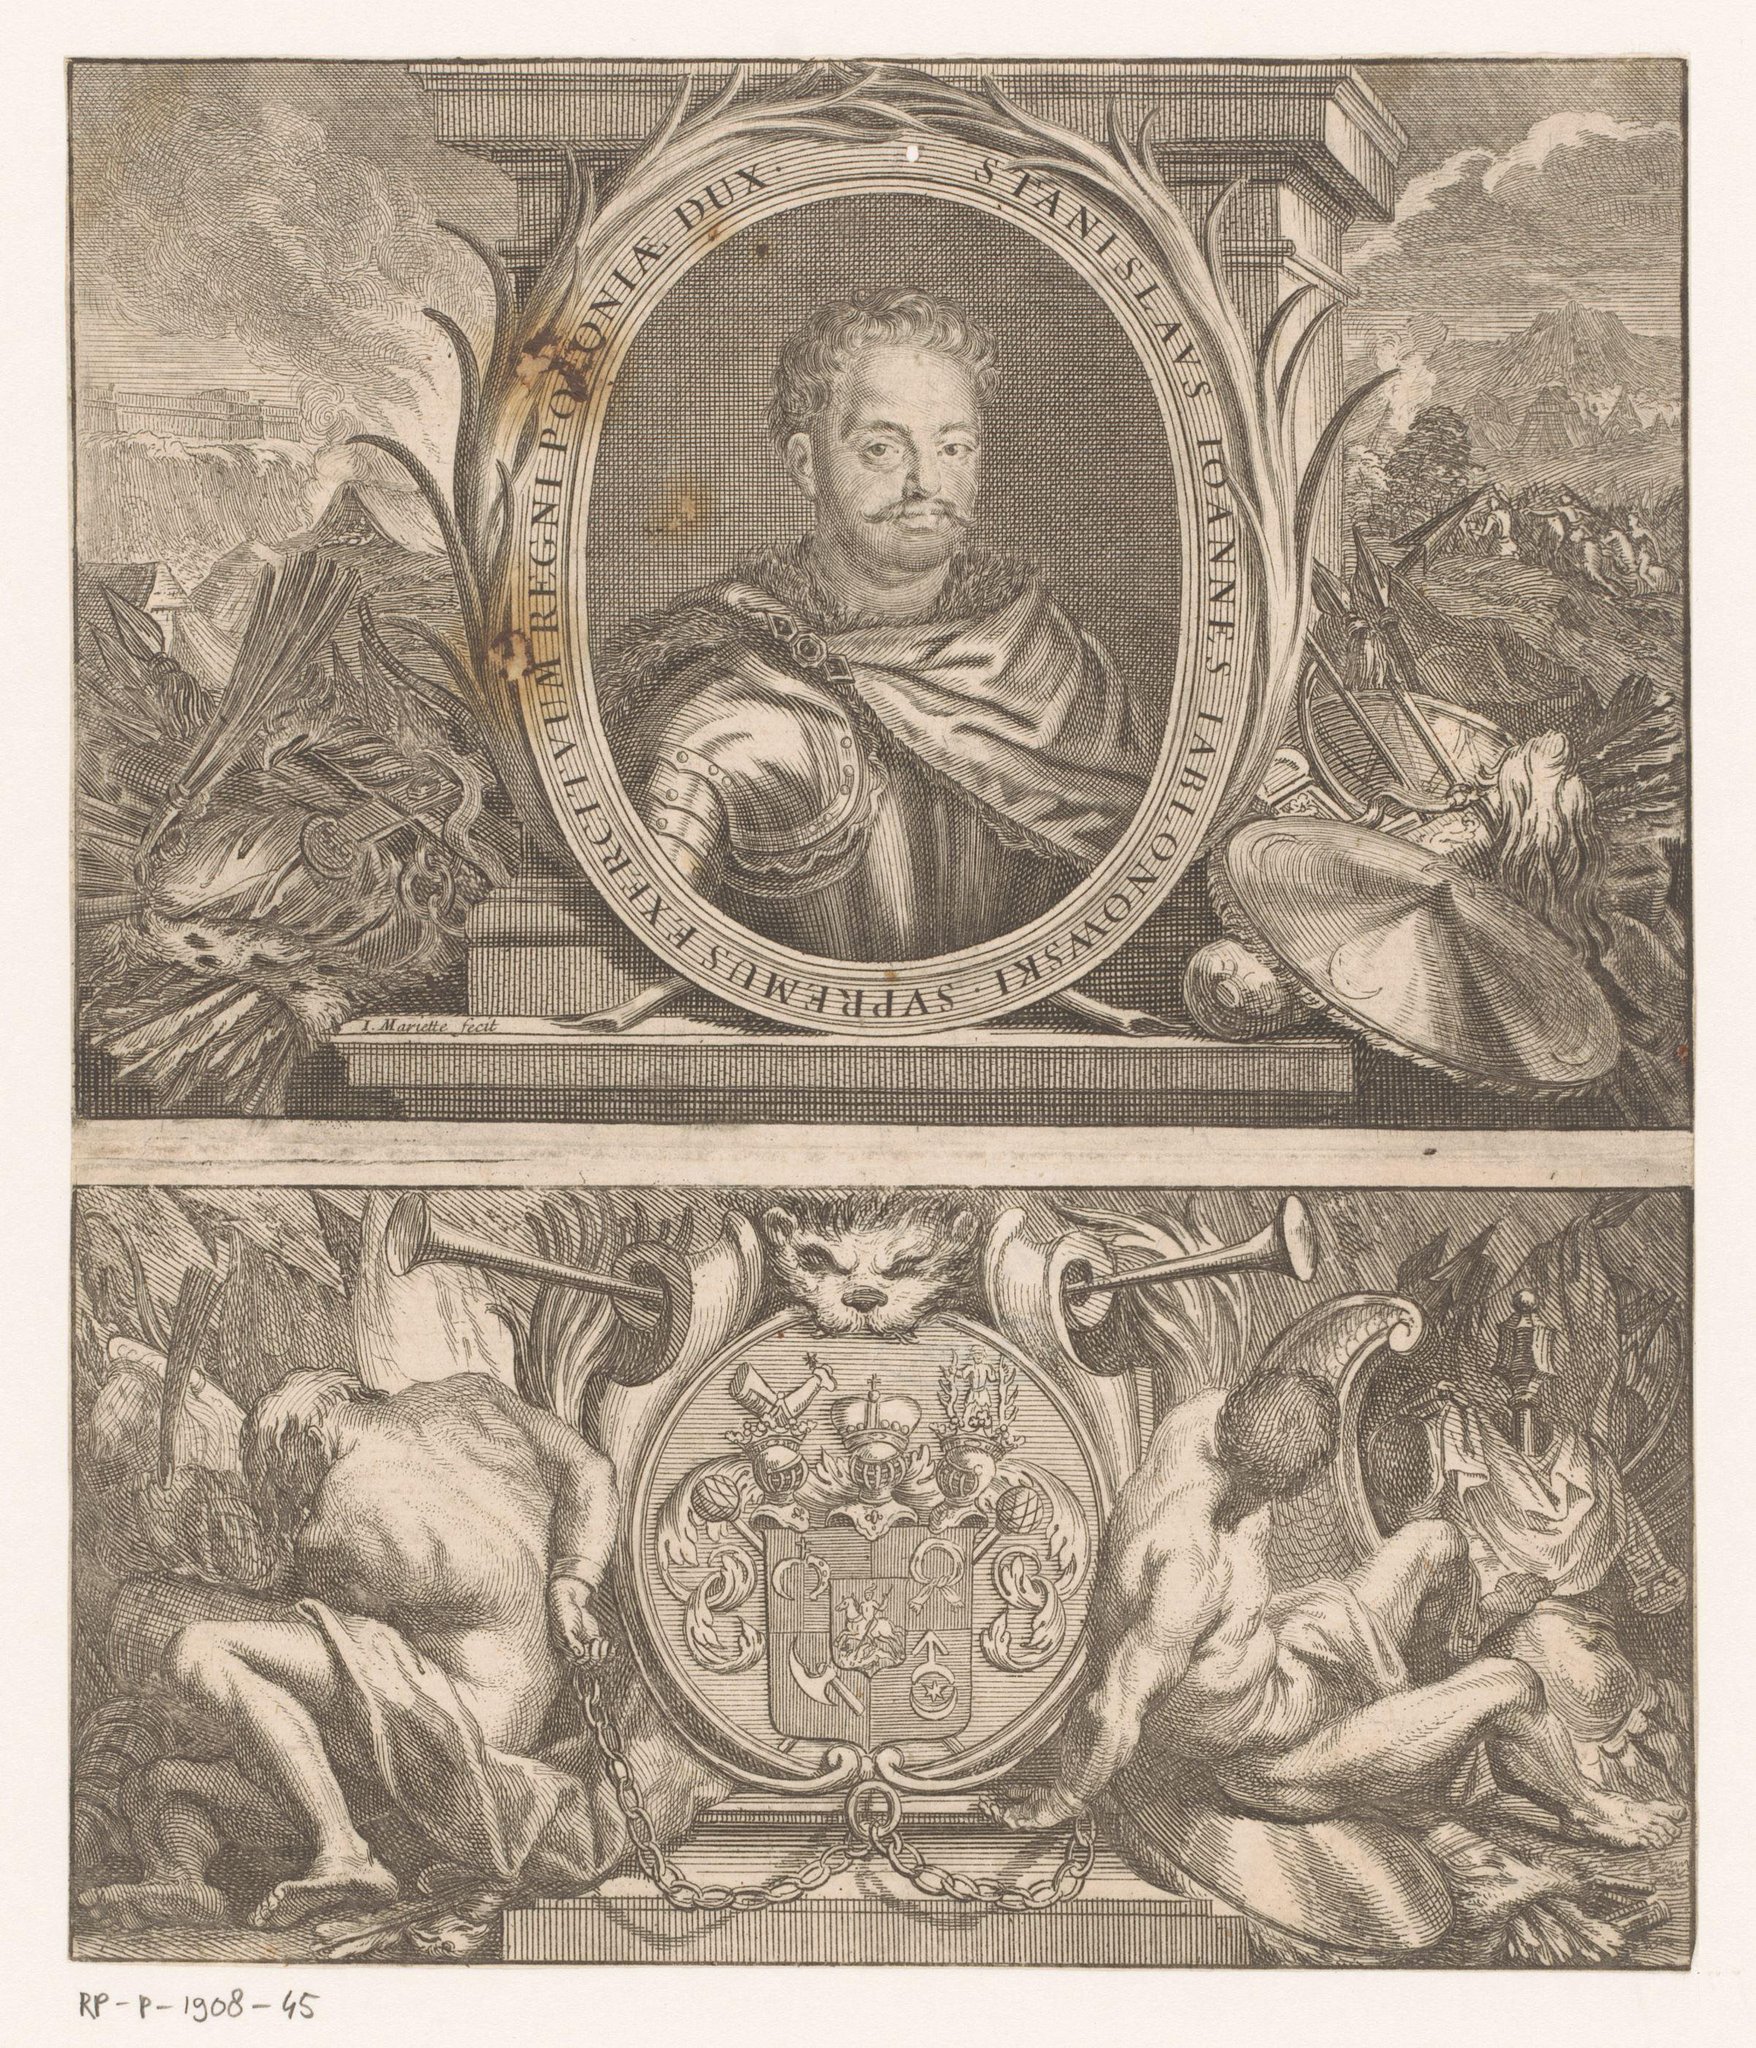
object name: print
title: Portret van Stanislaw Jan Jablonowski in medaillon omringd door oorlogsbuit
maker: jean mariette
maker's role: print maker, publisher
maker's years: 1660-1742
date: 1670-1742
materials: paper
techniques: engraving, etching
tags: historical persons, booty, spoil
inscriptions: inscription: ‘272 fr’, collector's mark: Lugt 2228